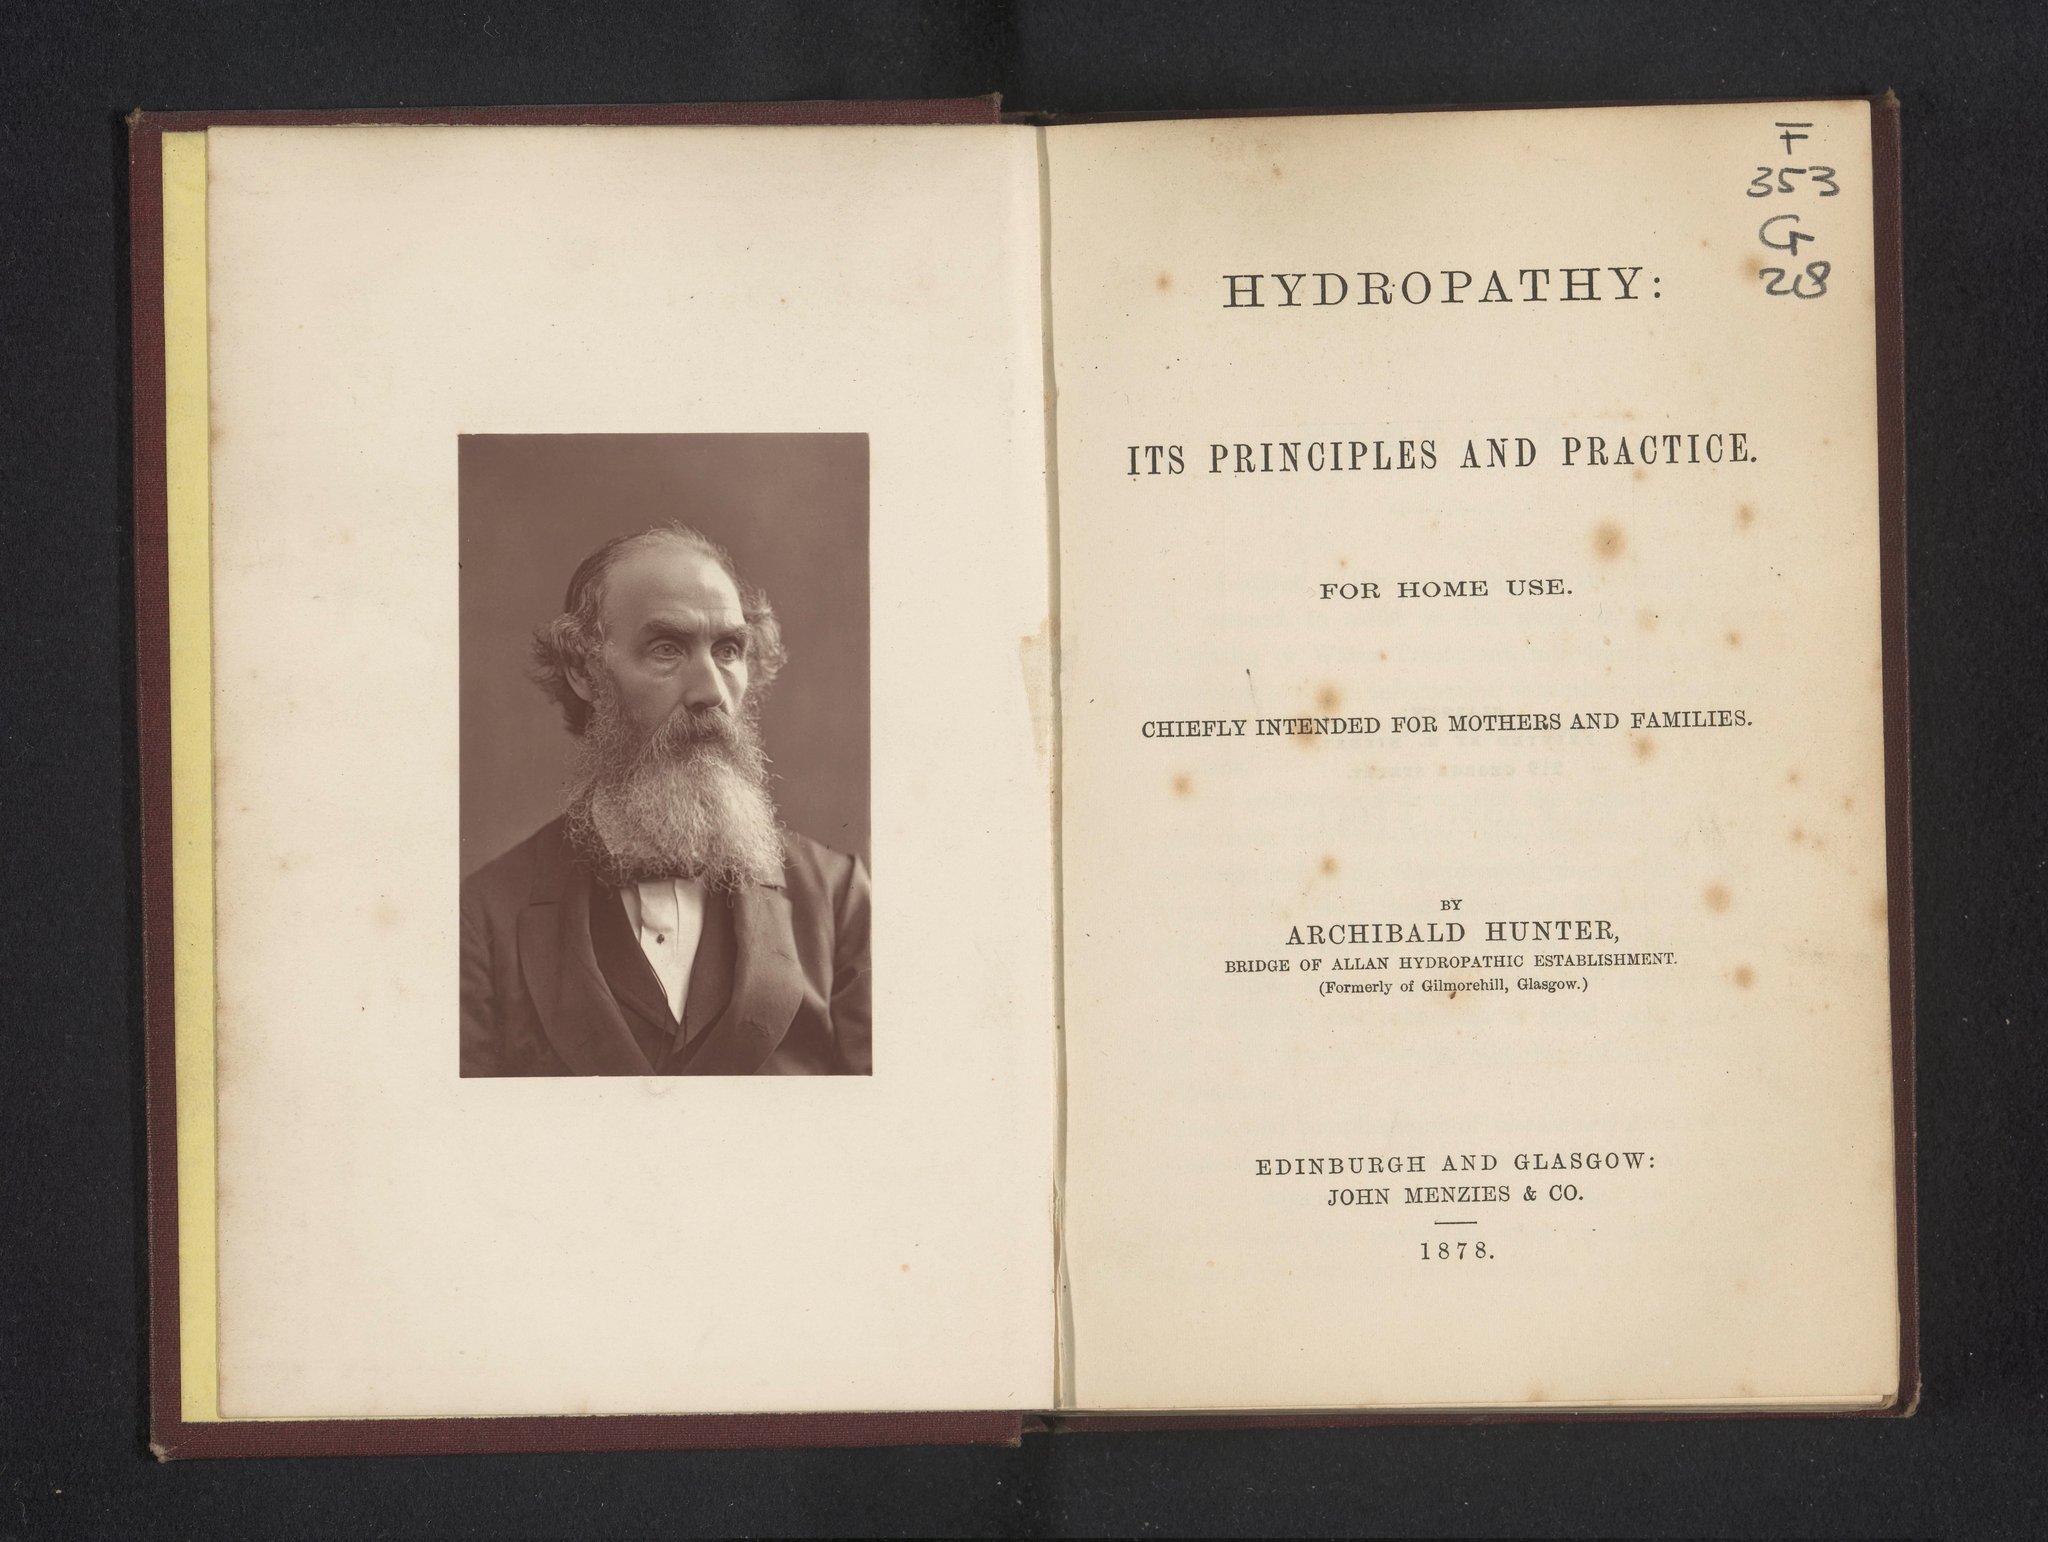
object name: book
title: Hydropathy: its principles and practice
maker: archibald hunter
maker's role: schrijver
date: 1878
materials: cardboard, linen, paper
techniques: printing, woodburytype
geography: edinburgh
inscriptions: inscription: ‘ex libris SFJ’